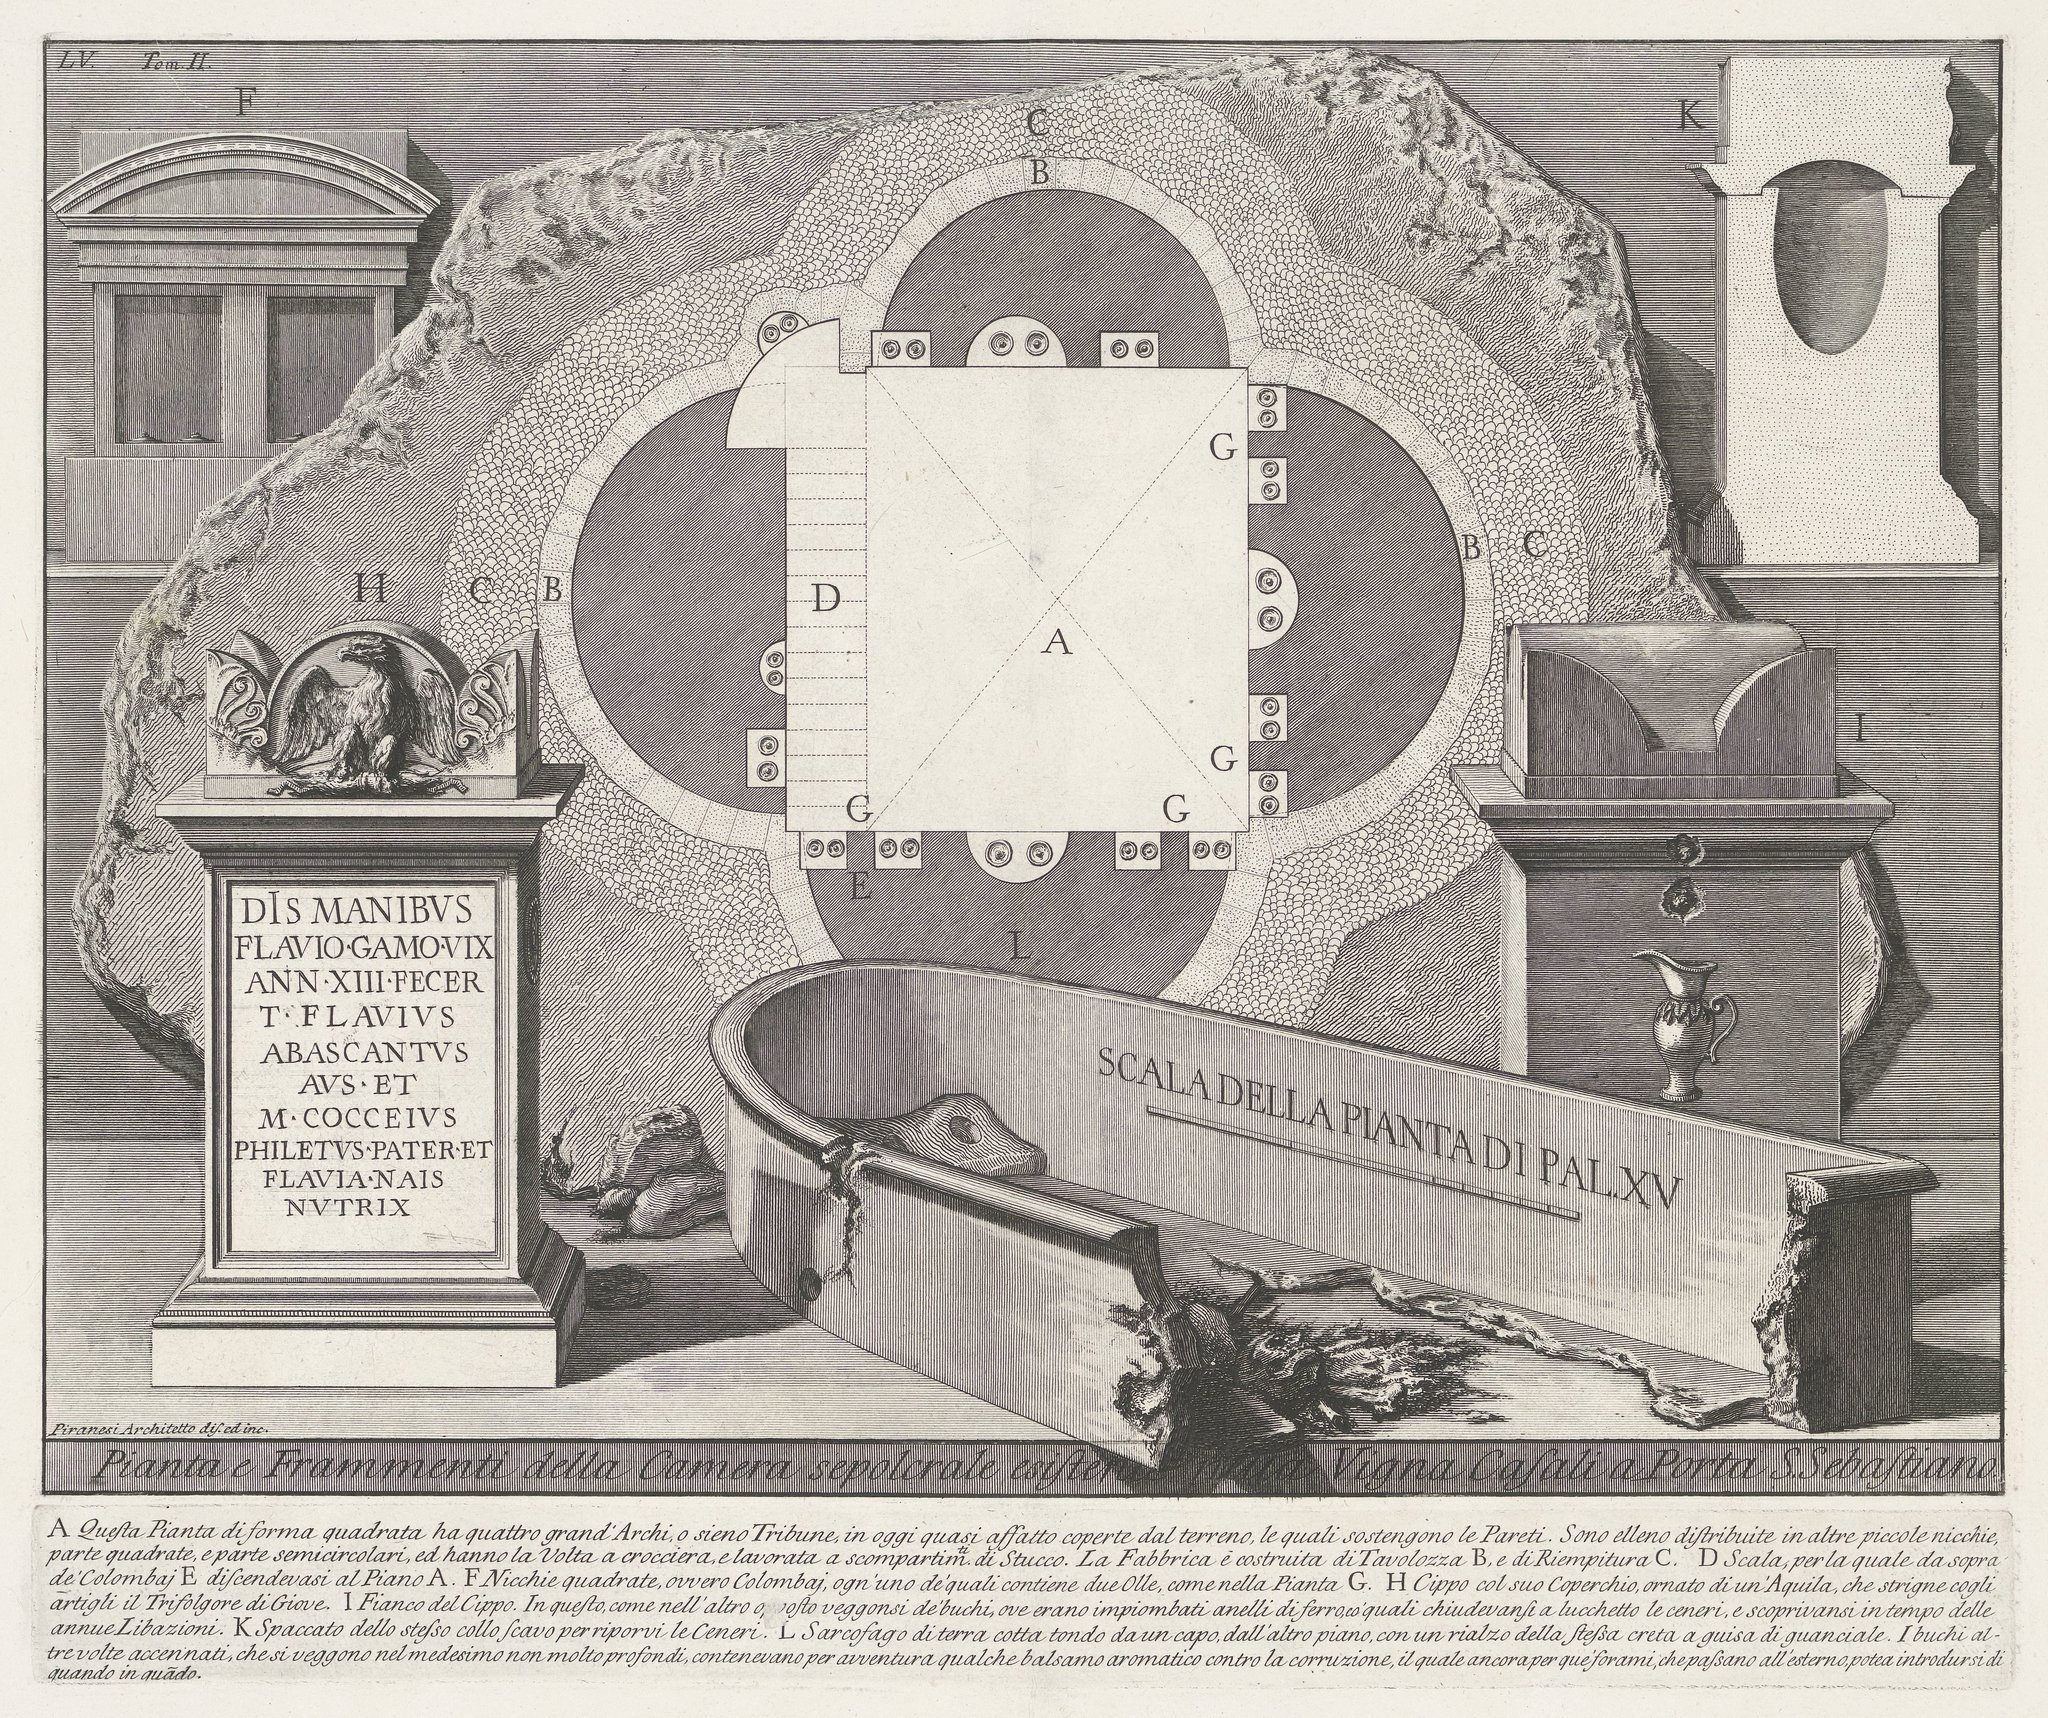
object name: print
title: Le Antichità Romane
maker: giovanni battista piranesi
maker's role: designer, draughtsman, print maker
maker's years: 1720-1778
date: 1756-1757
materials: paper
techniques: etching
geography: rome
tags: inscription, grave, tomb, sarcophagus, plan ~ architecture, italy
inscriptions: collector's mark: Lugt 2228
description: Deze prent maakt deel uit van de serie 'Le Antichità Romane'. Piranesi deed meer dan acht jaar voorstudie voor deze 250 platen tellende serie die in vier volumes werd uitgegeven. Hij produceerde de prenten tussen ca. 1756 en 1757. De serie bevat ook prenten door of naar andere prentmakers, onder wie Francesco Bianchini en Girolamo Rossi.